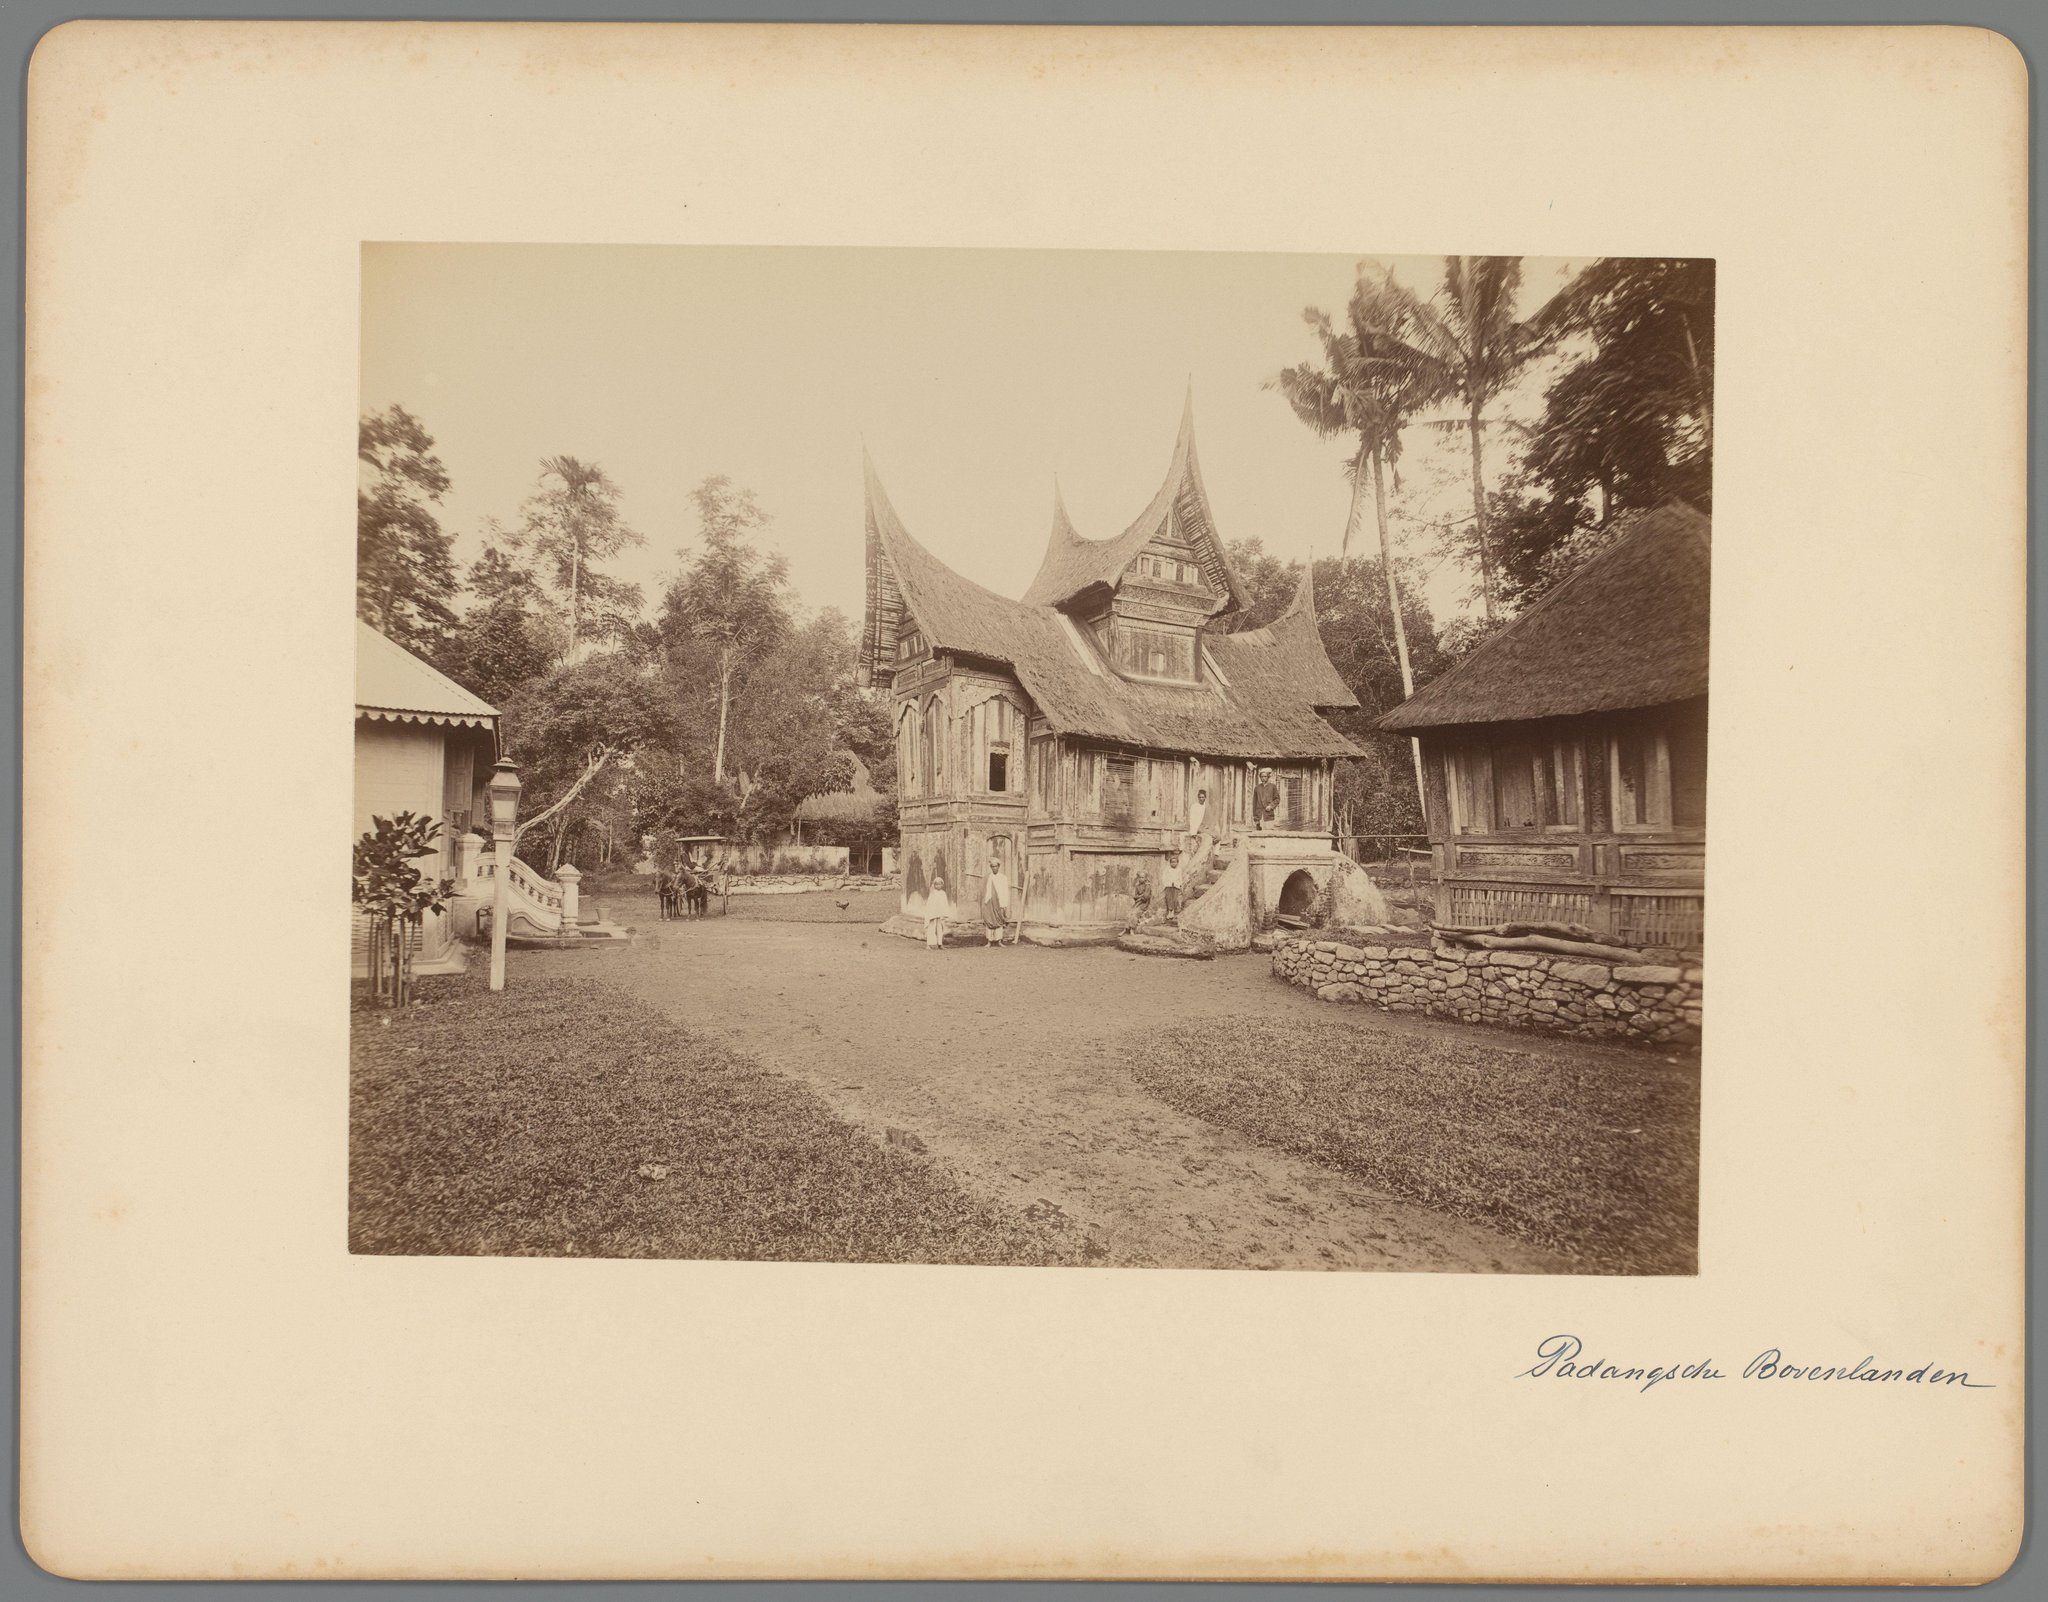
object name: photograph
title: Padangsche Bovenlanden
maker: christiaan benjamin nieuwenhuis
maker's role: publisher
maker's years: 1863-1922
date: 1891-1895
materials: cardboard, paper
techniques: albumen print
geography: sumatera barat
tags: village, sumatera barat (province)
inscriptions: inscription: ‘Foto’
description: Deze foto zat oorspronkelijk in prentenkabinet RP-F-AA3192.